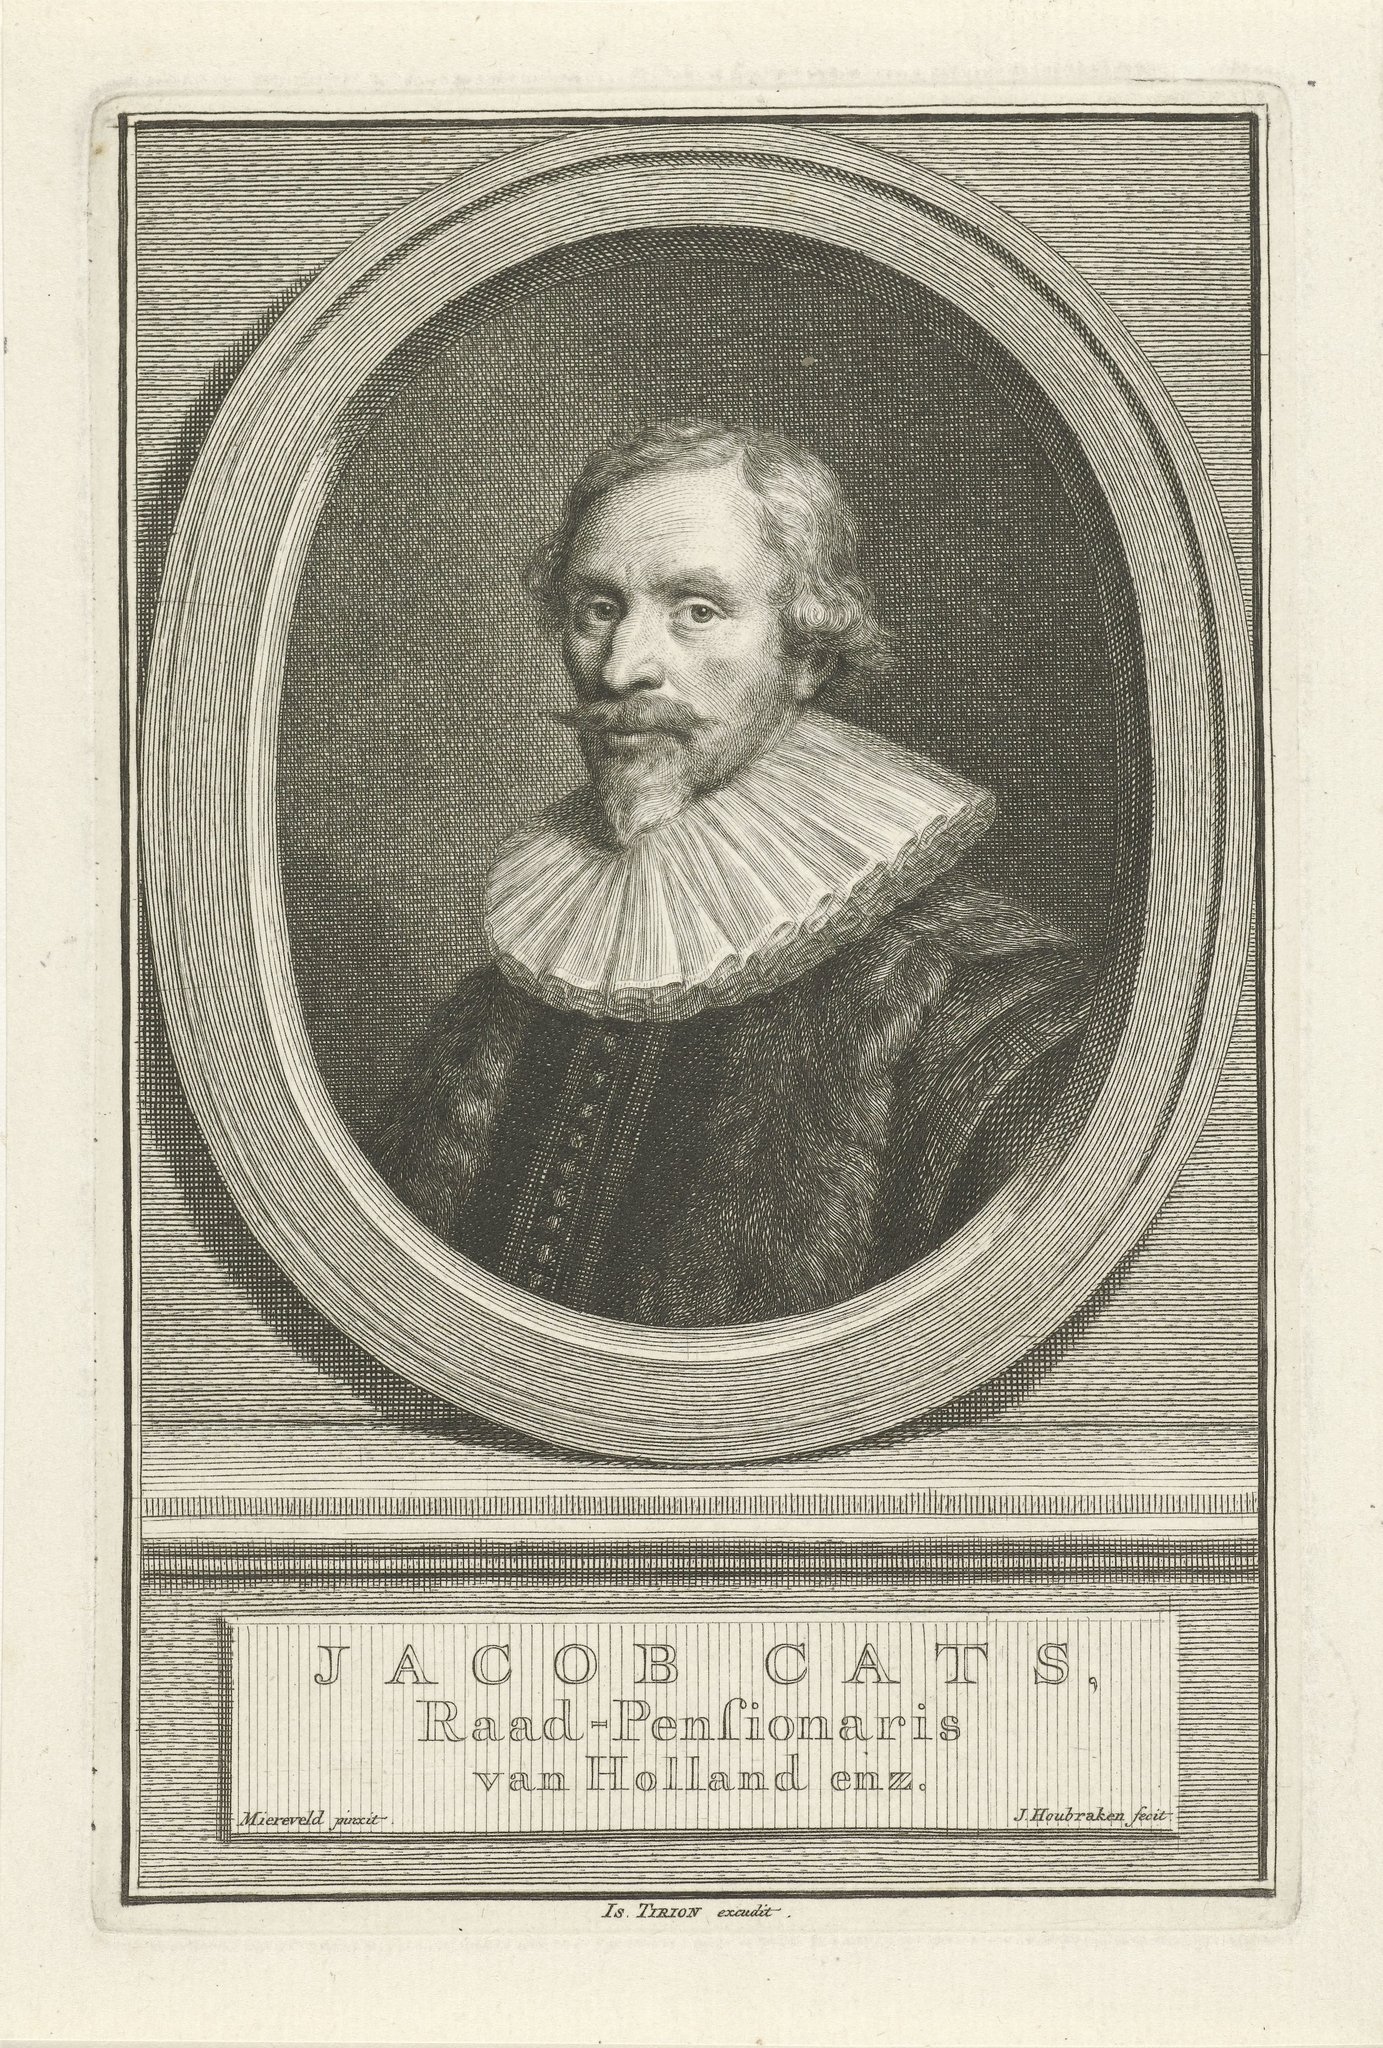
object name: print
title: Portret van Jacob Cats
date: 1749-1759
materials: paper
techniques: engraving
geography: amsterdam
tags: jacob cats (1577-1660), historical persons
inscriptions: collector's mark: Lugt 240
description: Prent ook gebruikt in: Jan Wagenaar, Vaderlandsche historie, vervattende de geschiedenissen der nu Vereenigde Nederlanden, inzonderheid die van Holland (...), 21 delen. Amsterdam, Isaak Tirion, 1749-59. Prent volgens Ver Huell ook gebruikt in: Portraiten van eenige der vermaardste staatsmannen en zeehelden, als toevoeging op: Willem Tiberius Hattinga, Atlas van Zeeland. Amsterdam: Isaak Tirion, 1760.